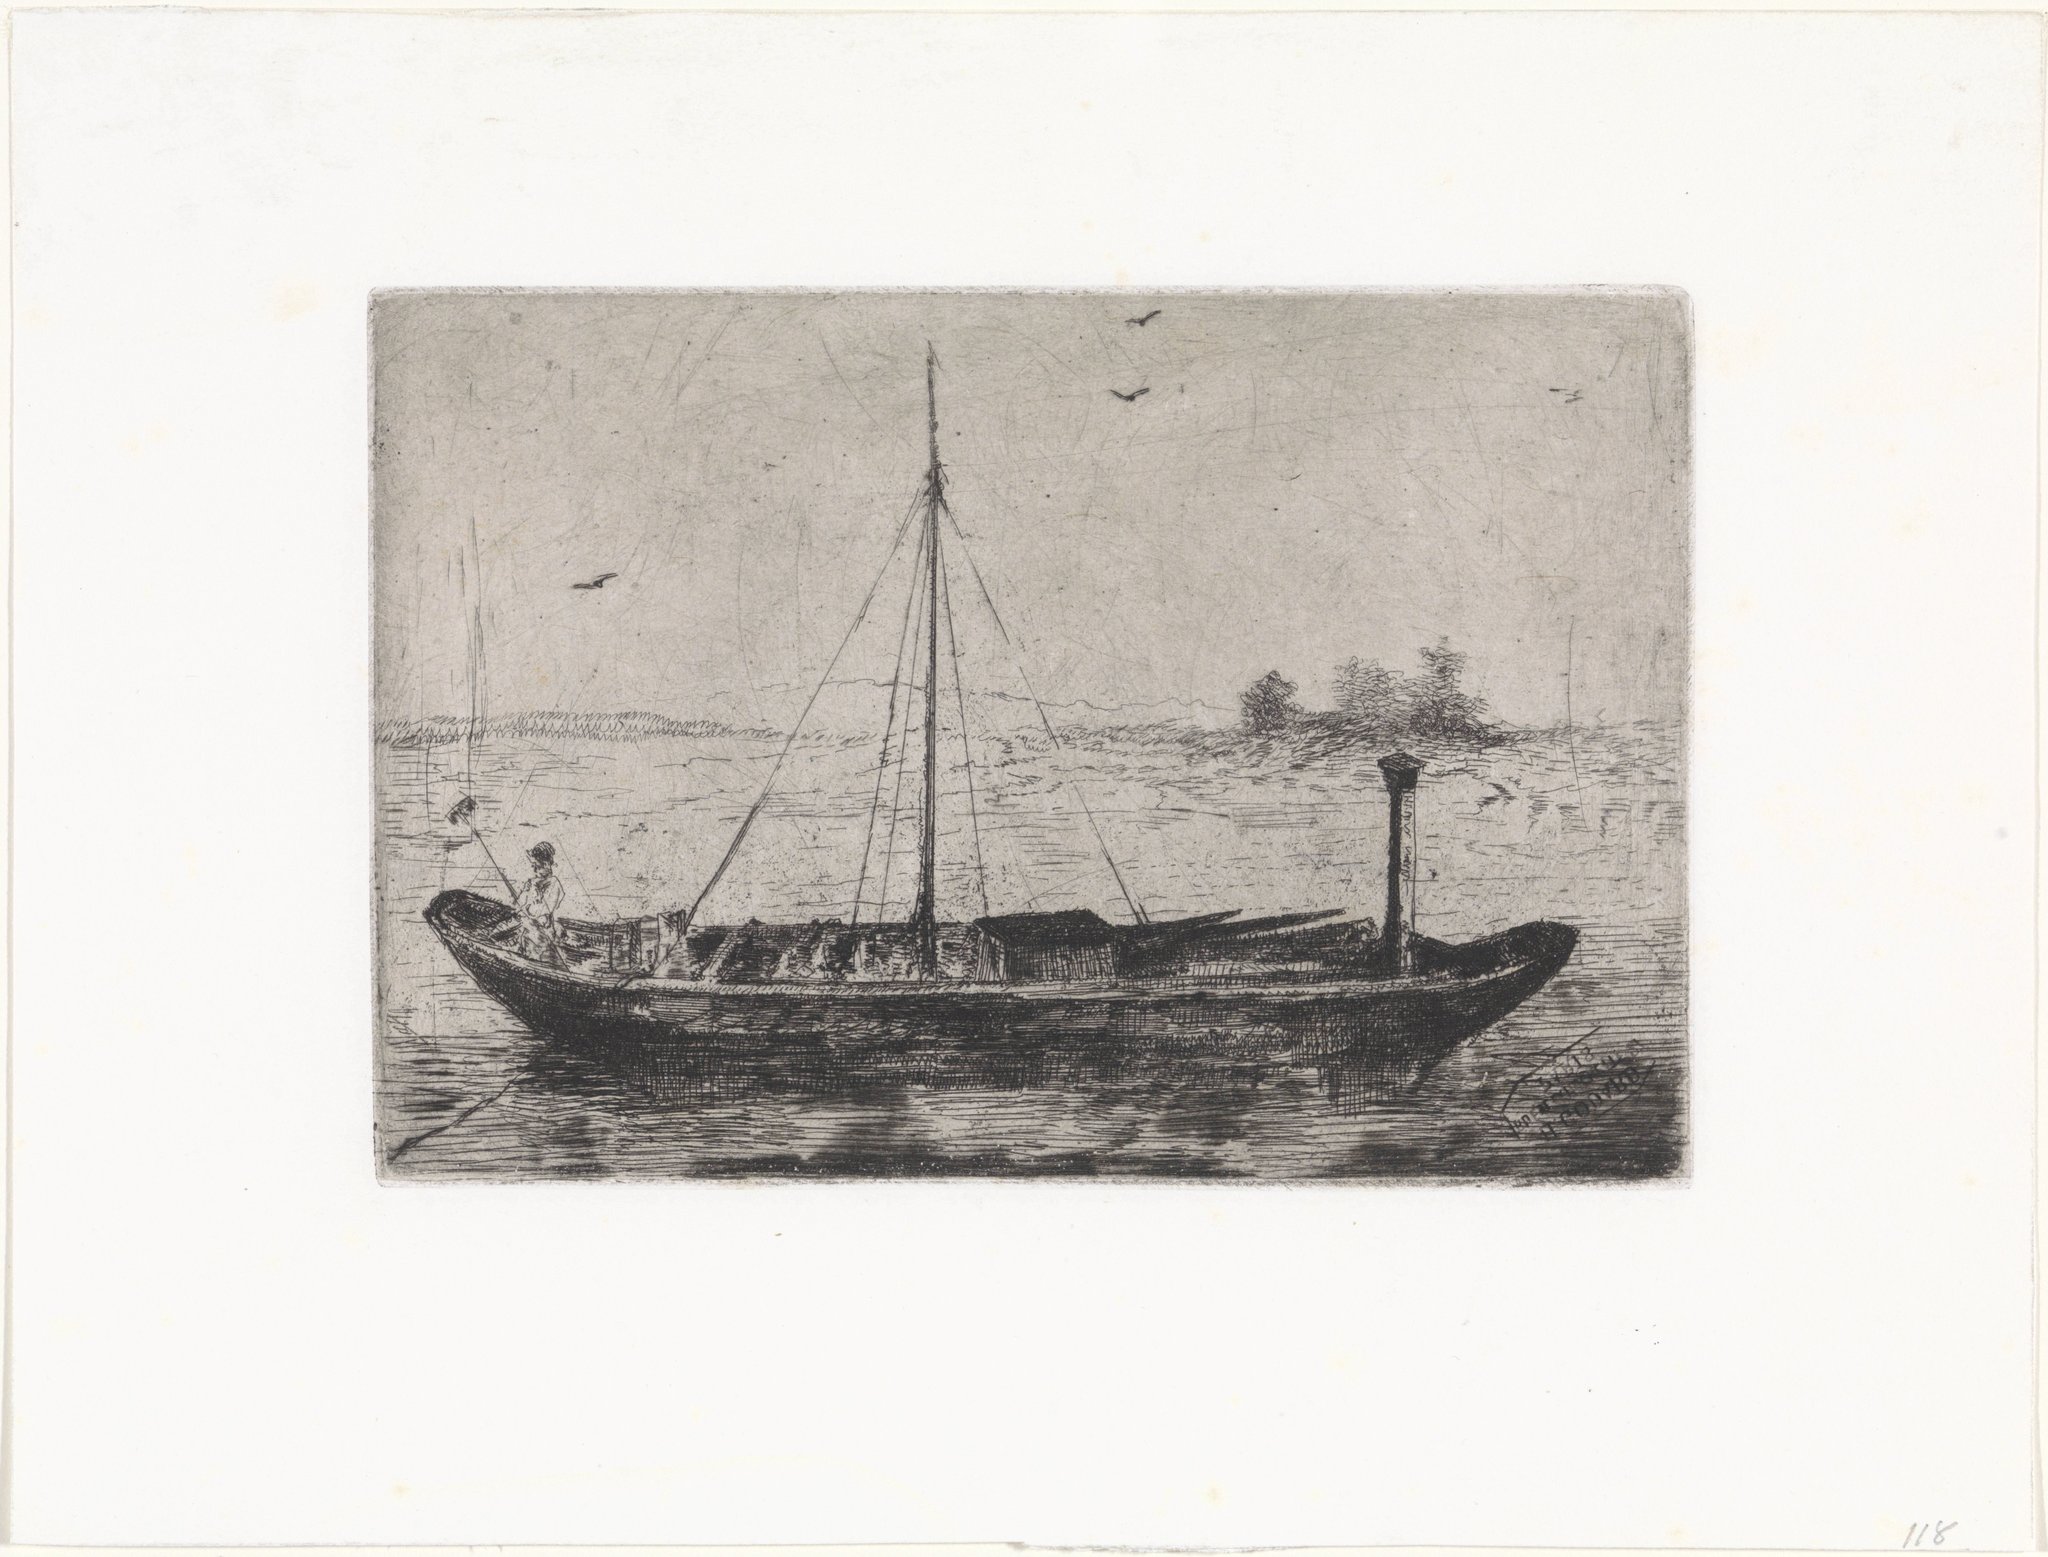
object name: print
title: Stoomboot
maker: arnoud schaepkens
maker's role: print maker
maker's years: 1816-1904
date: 1855-1904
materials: paper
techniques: drypoint, etching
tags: chimney, steamship, motorship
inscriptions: collector's mark: Lugt 2228, stamp: ‘H.Godard / Rue de la Huchette 27 / Paris (in spiegelbeeld)’